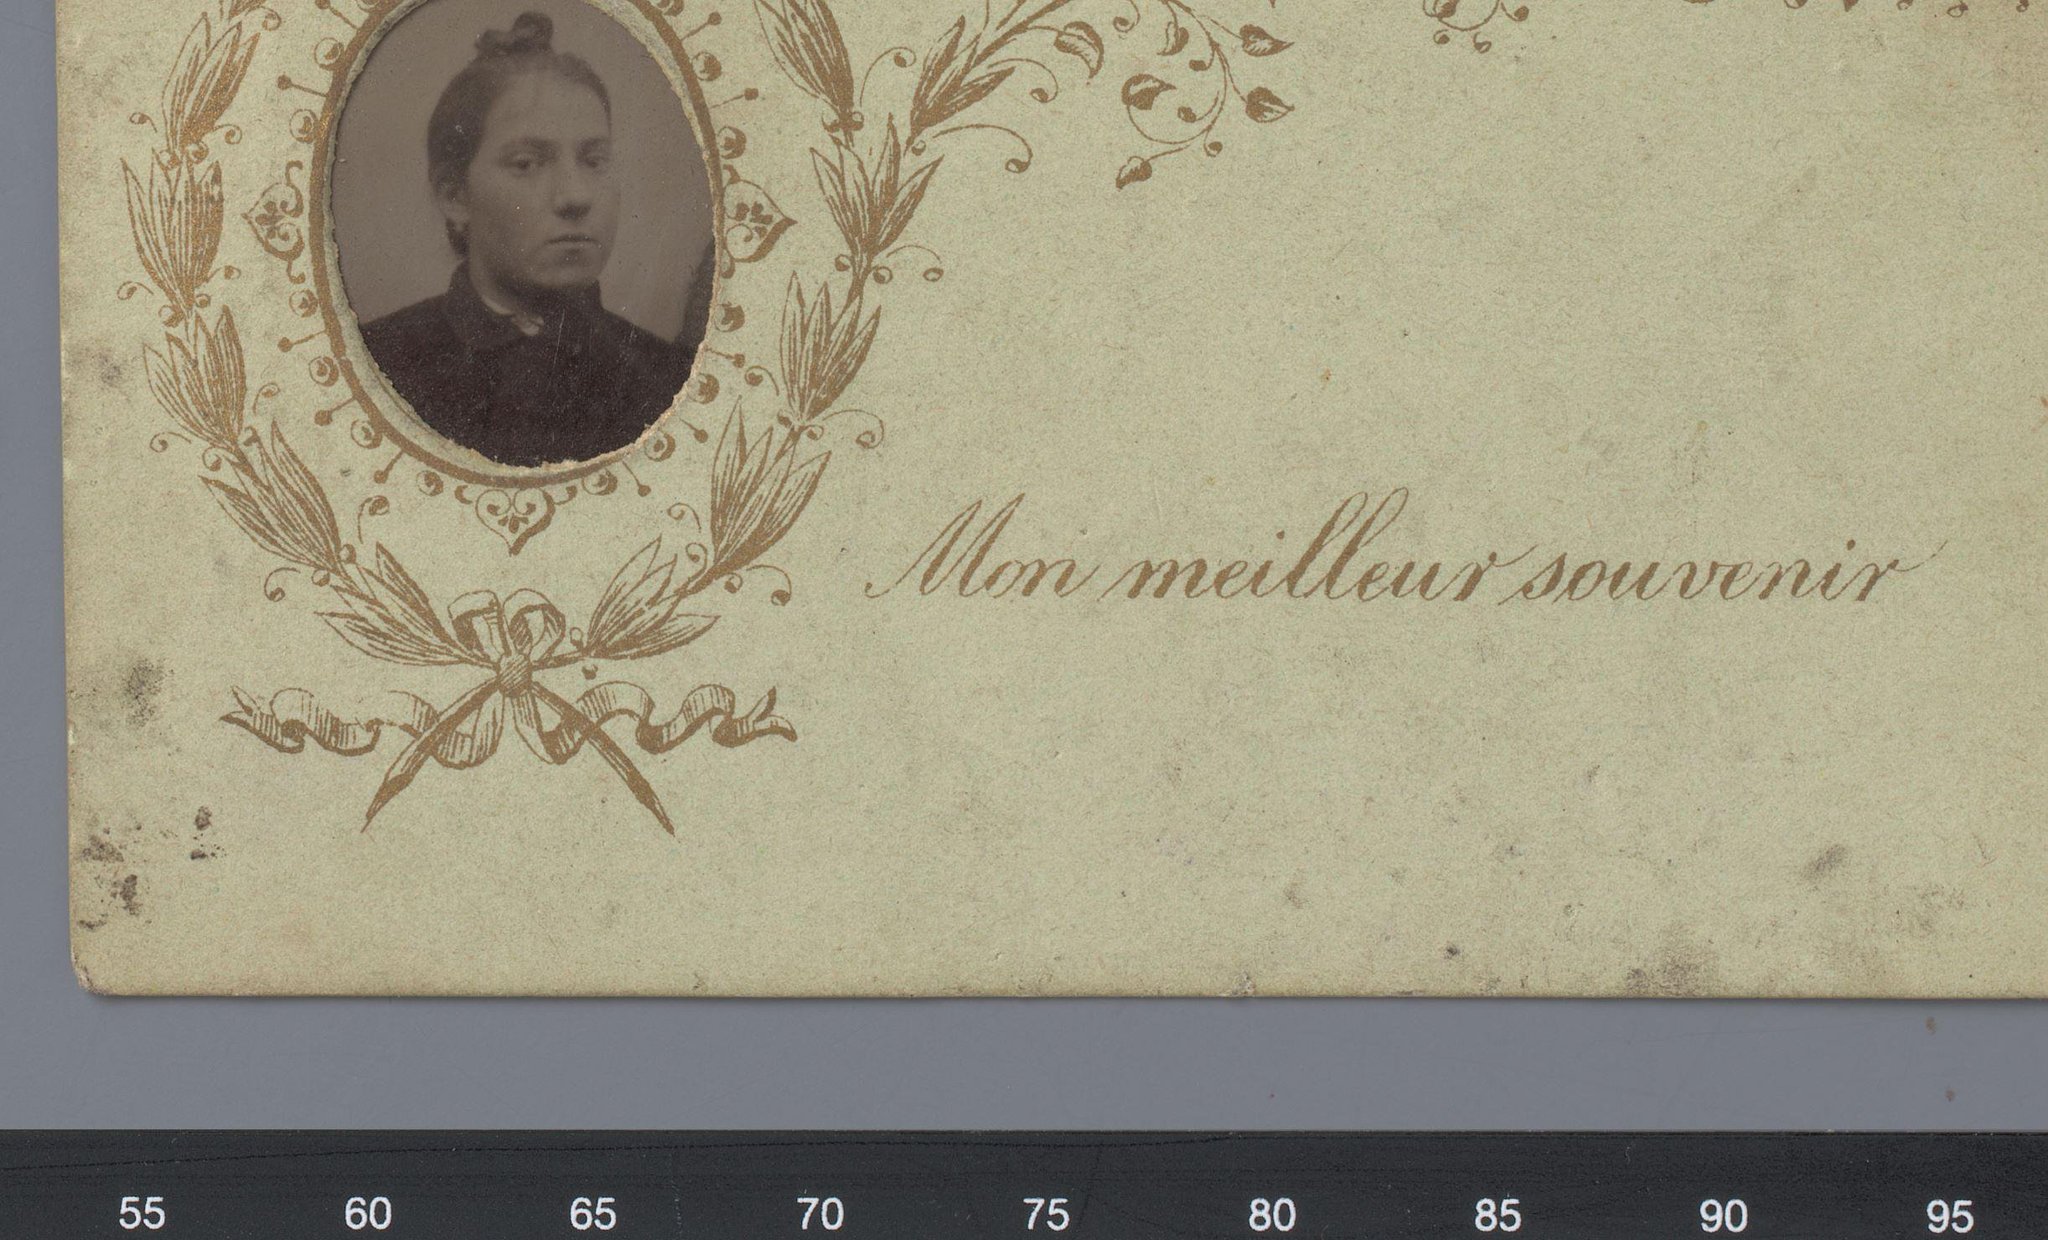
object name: photograph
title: Mon meilleur souvenir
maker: Anonymous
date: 1855-1900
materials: iron, paper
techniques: ferrotyping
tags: adolescent, young woman, maiden, historical persons - bb - woman